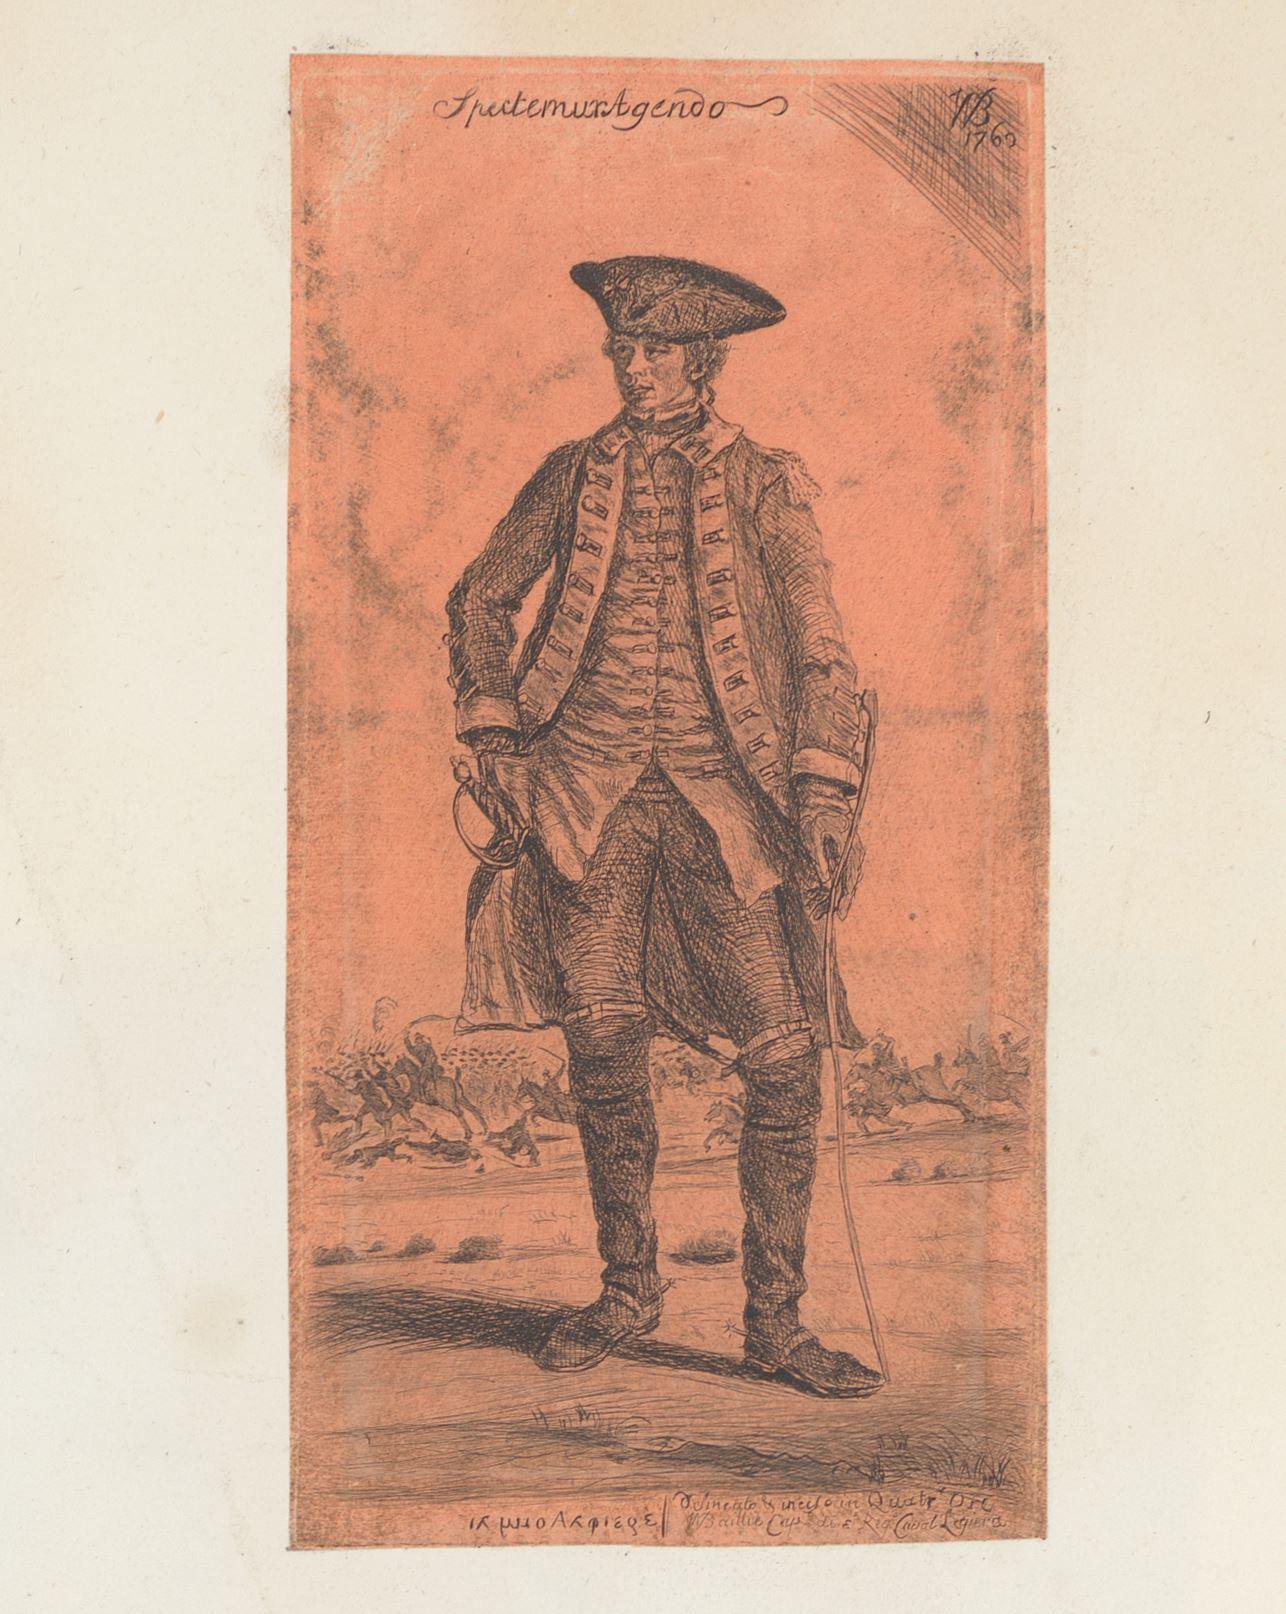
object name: album leaf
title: Spectemur Agendo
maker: william baillie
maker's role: print maker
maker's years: 1723-1810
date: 1760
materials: paper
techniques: etching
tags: ranks in the army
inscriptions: date